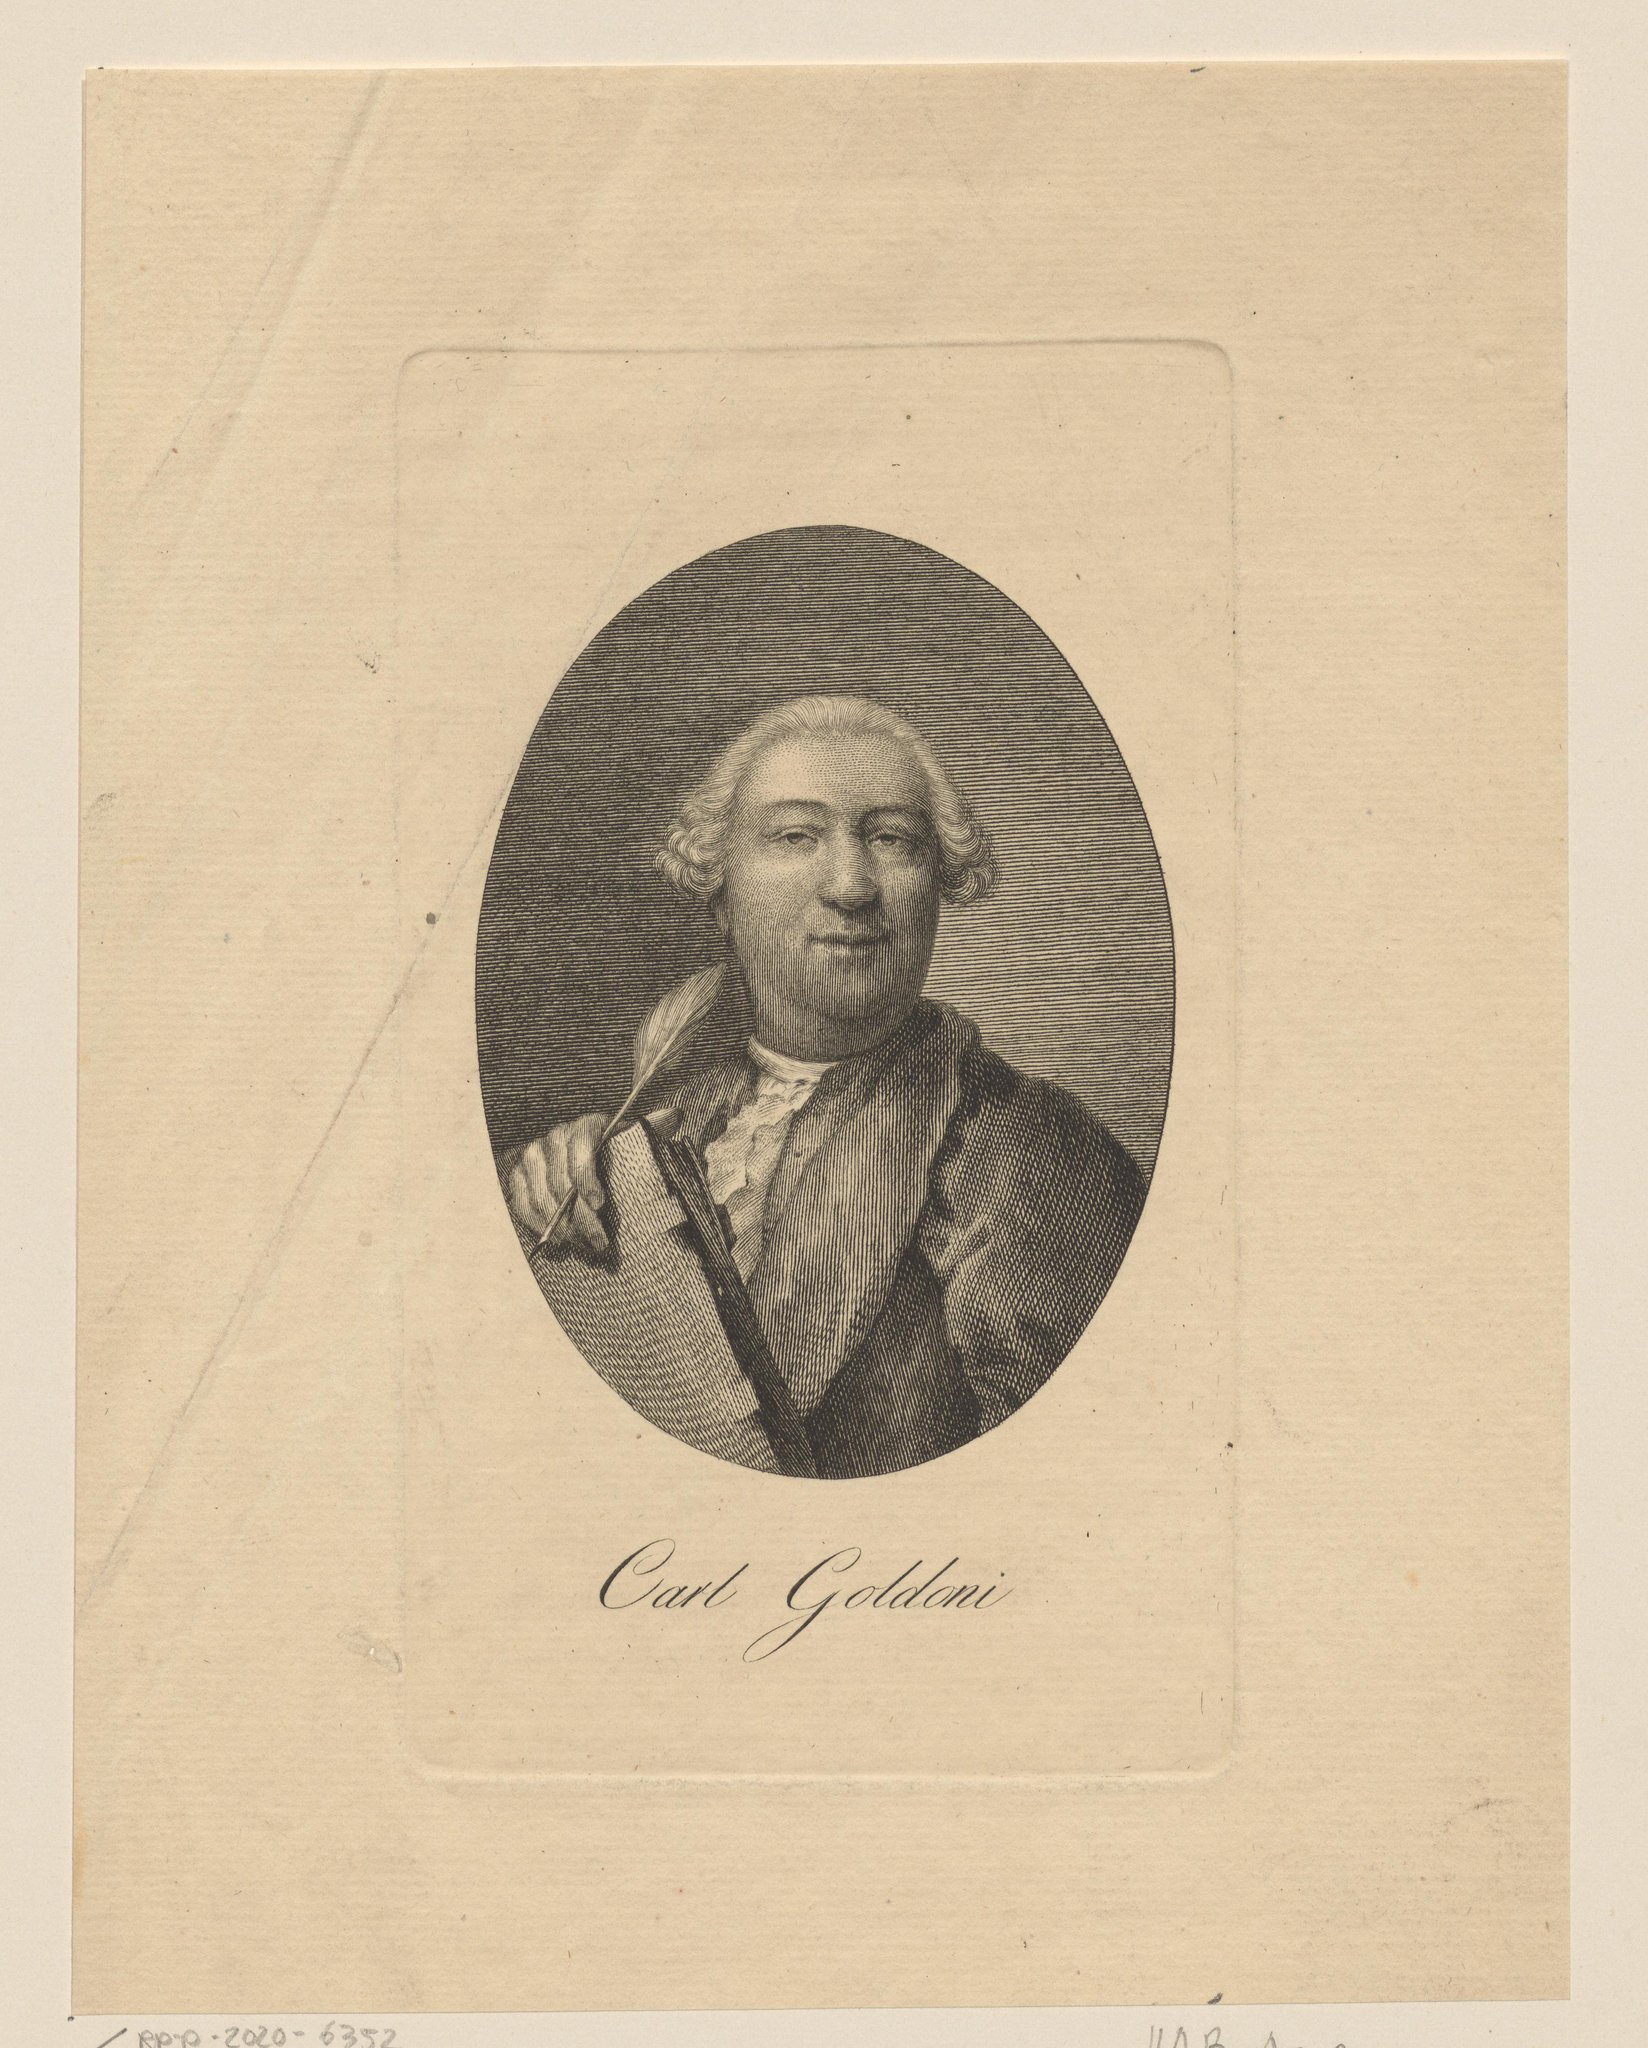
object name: print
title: Portret van Carlo Goldoni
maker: Anonymous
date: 1761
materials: paper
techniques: engraving, etching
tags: venice, paris, carlo goldoni, historical persons, writer, poet, author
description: Prent mogelijk uit: Goldoni, Carlo. Delle Commedie di Carlo Goldoni. Venetië: Giovanni Battista Pasquali, [1761].